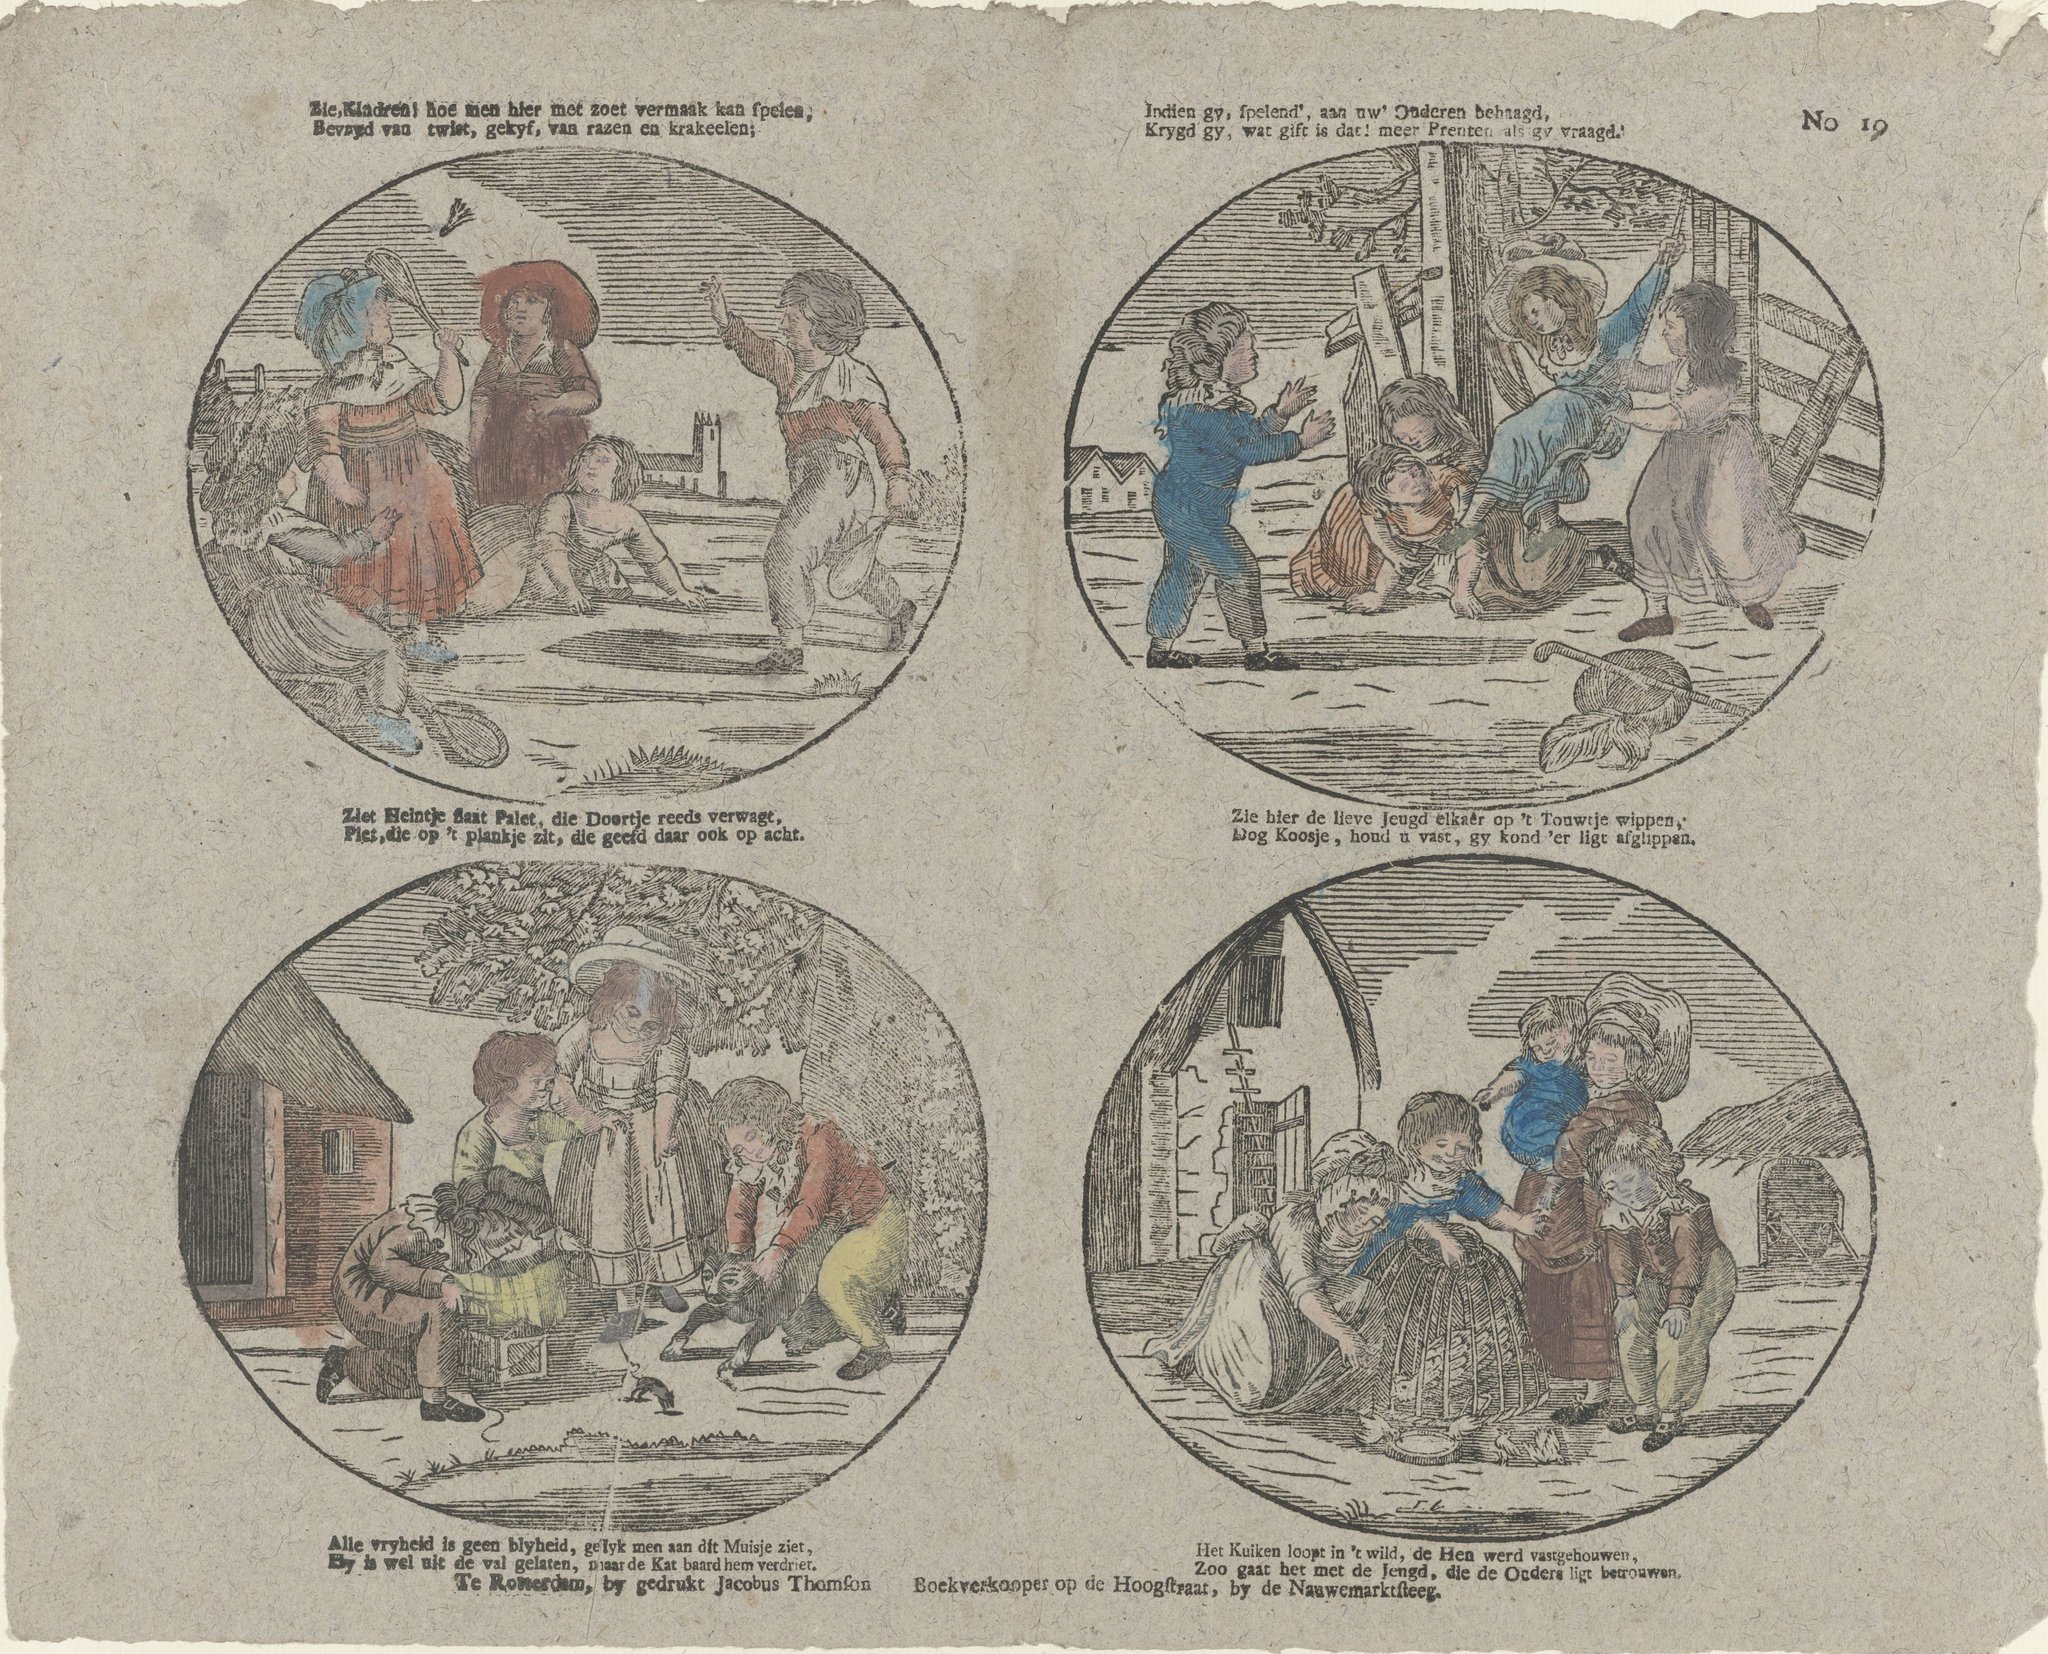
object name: print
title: Zie, kindren! hoe men hier met zoet vermaak kan spelen, / Bevryd van twist, gekyf, van razen en krakeelen; / Indien gy, spelend', aan uw' Ouderen behaagd, / Krygd gy, wat gift is dat! meer prenten als gy vraagd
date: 1791-1812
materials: paper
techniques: colour, letterpress printing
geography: netherlands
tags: tennis, lawn-tennis, children's games and plays, child playing with animals, swinging (children's game)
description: Blad met 4 ovale voorstellingen van bezigheden voor kinderen, zoals badmintonnen, schommelen op een touw en spelen met dieren. Onder elke afbeelding een tweeregelig vers. Genummerd rechtsboven: No. 19.